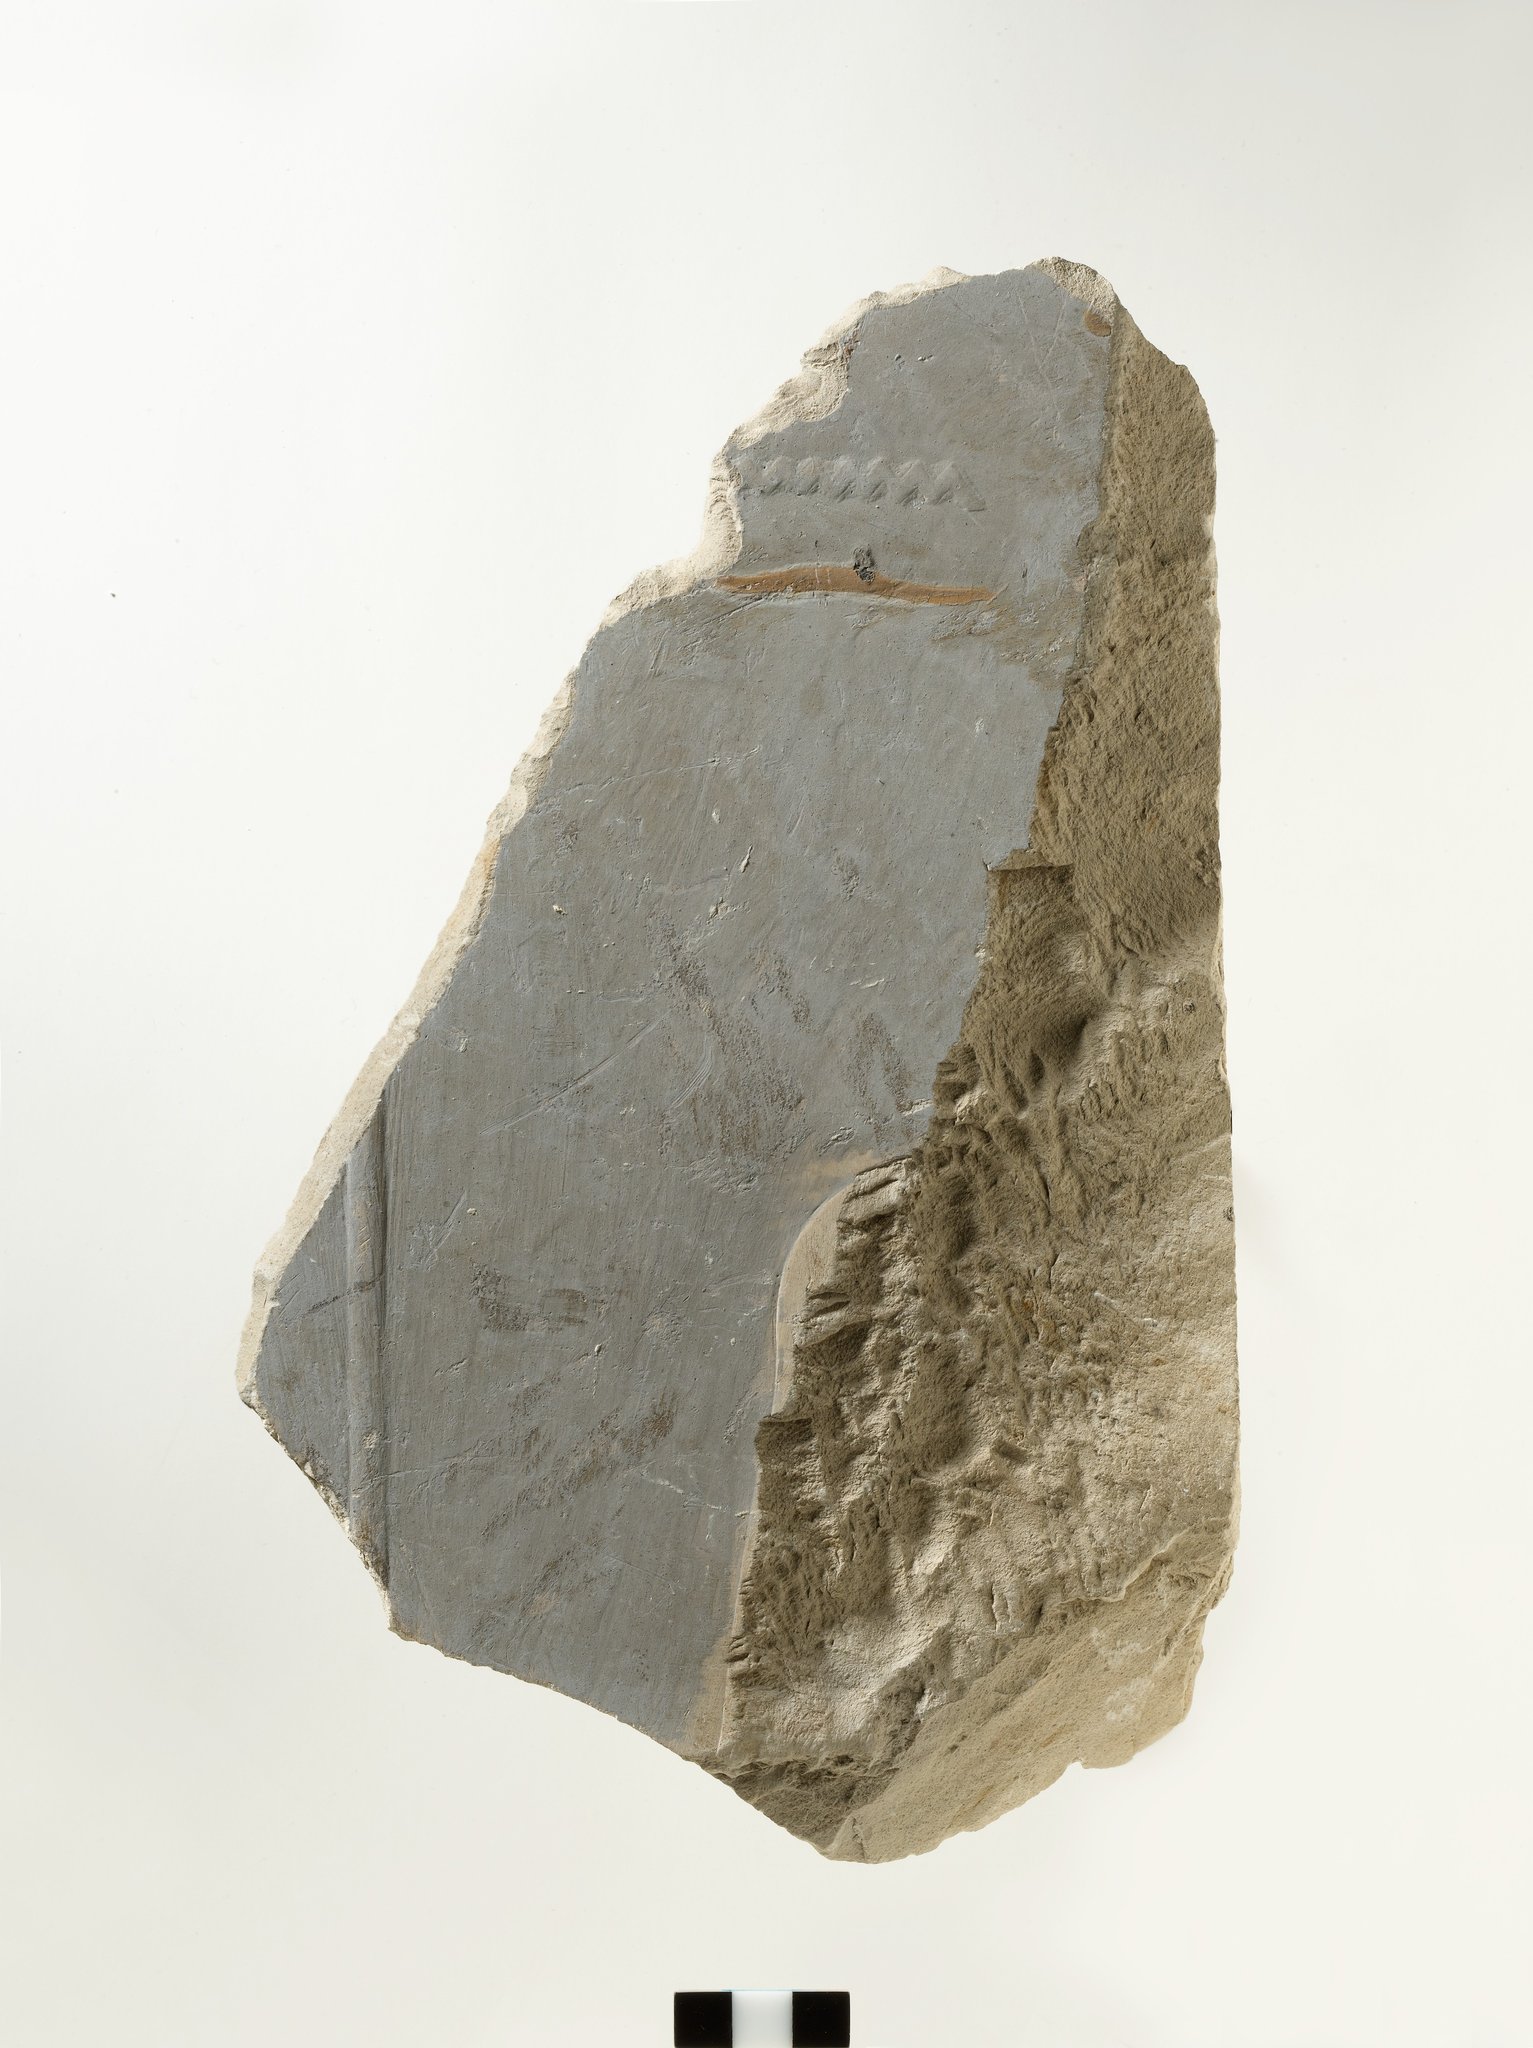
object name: relief fragment, tomb of meketre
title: Reliefs from the tomb of Meketre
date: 1981-1975 BCE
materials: limestone, paint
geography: egypt